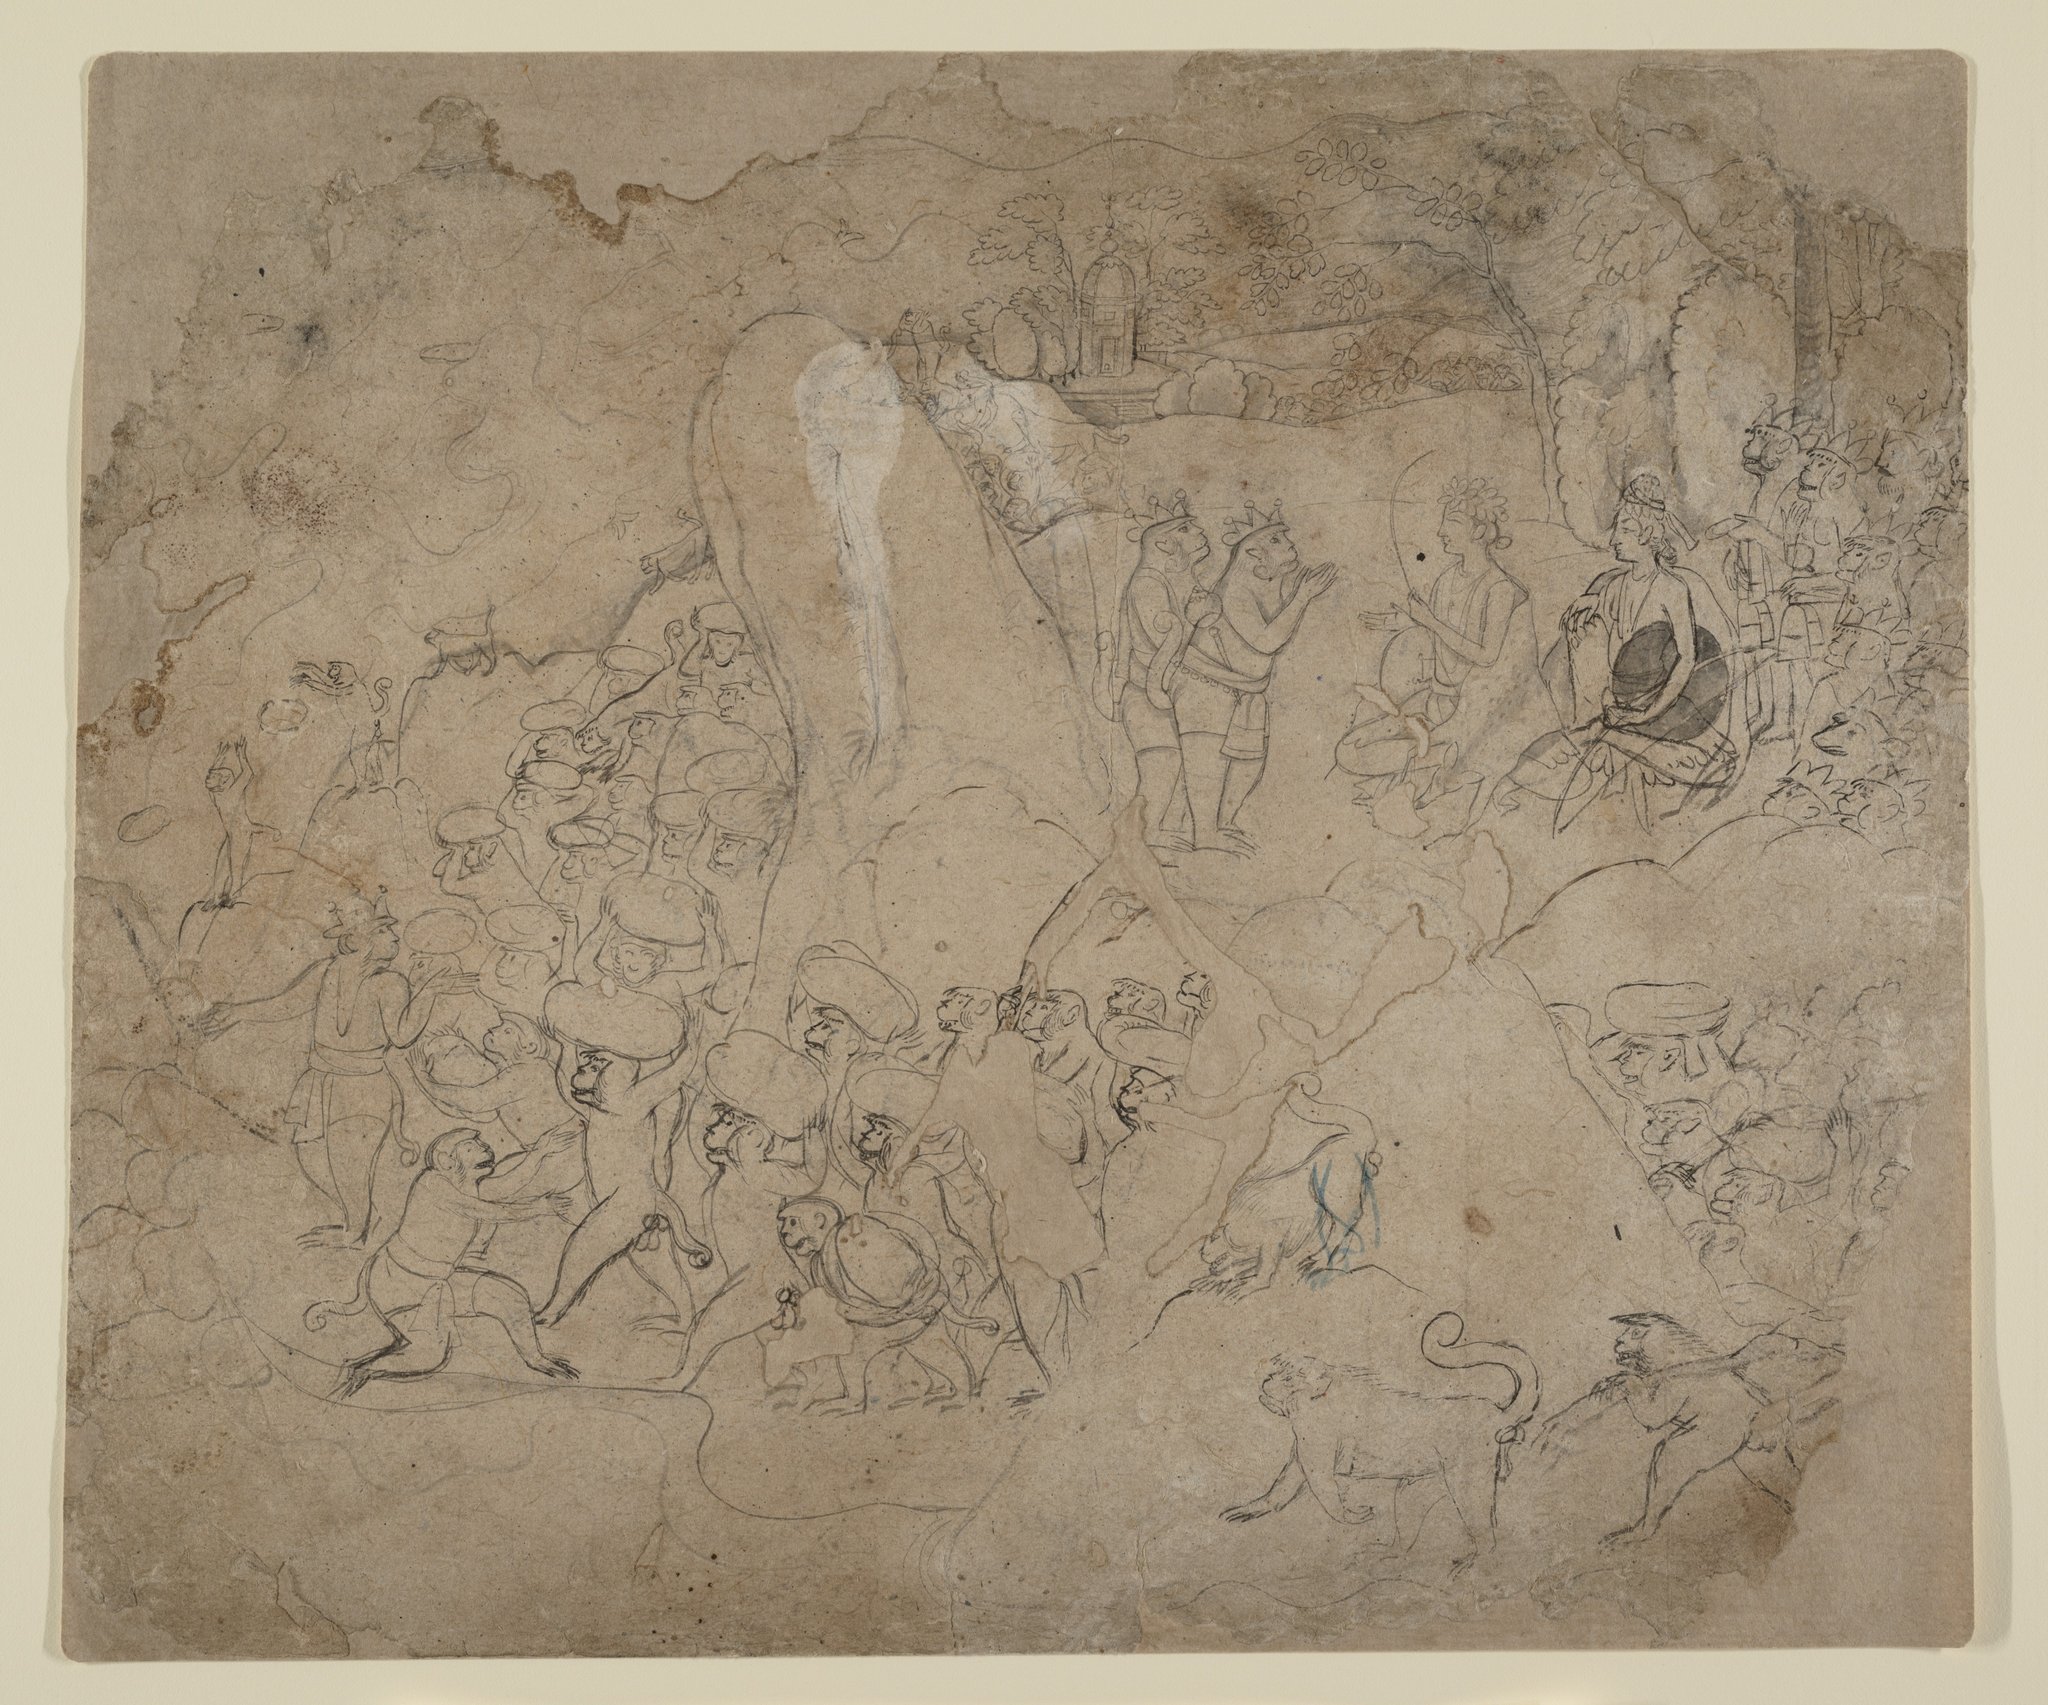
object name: painting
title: Building the Bridge to Lanka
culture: india, pahari hills, kangra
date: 1800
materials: ink, paper, watercolor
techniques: wash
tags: bridges,monkeys